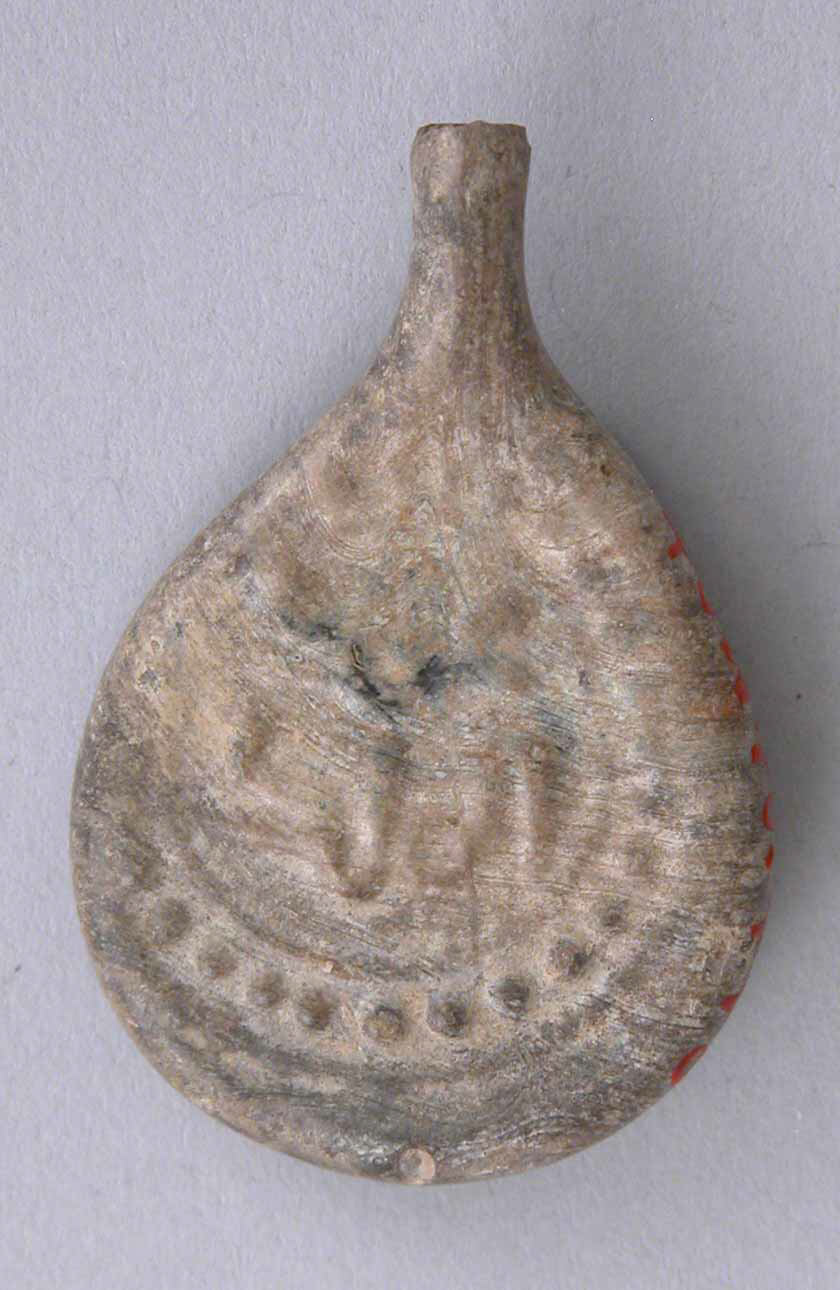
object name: seal impression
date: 701-1000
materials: glass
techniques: molding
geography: iran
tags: arabic